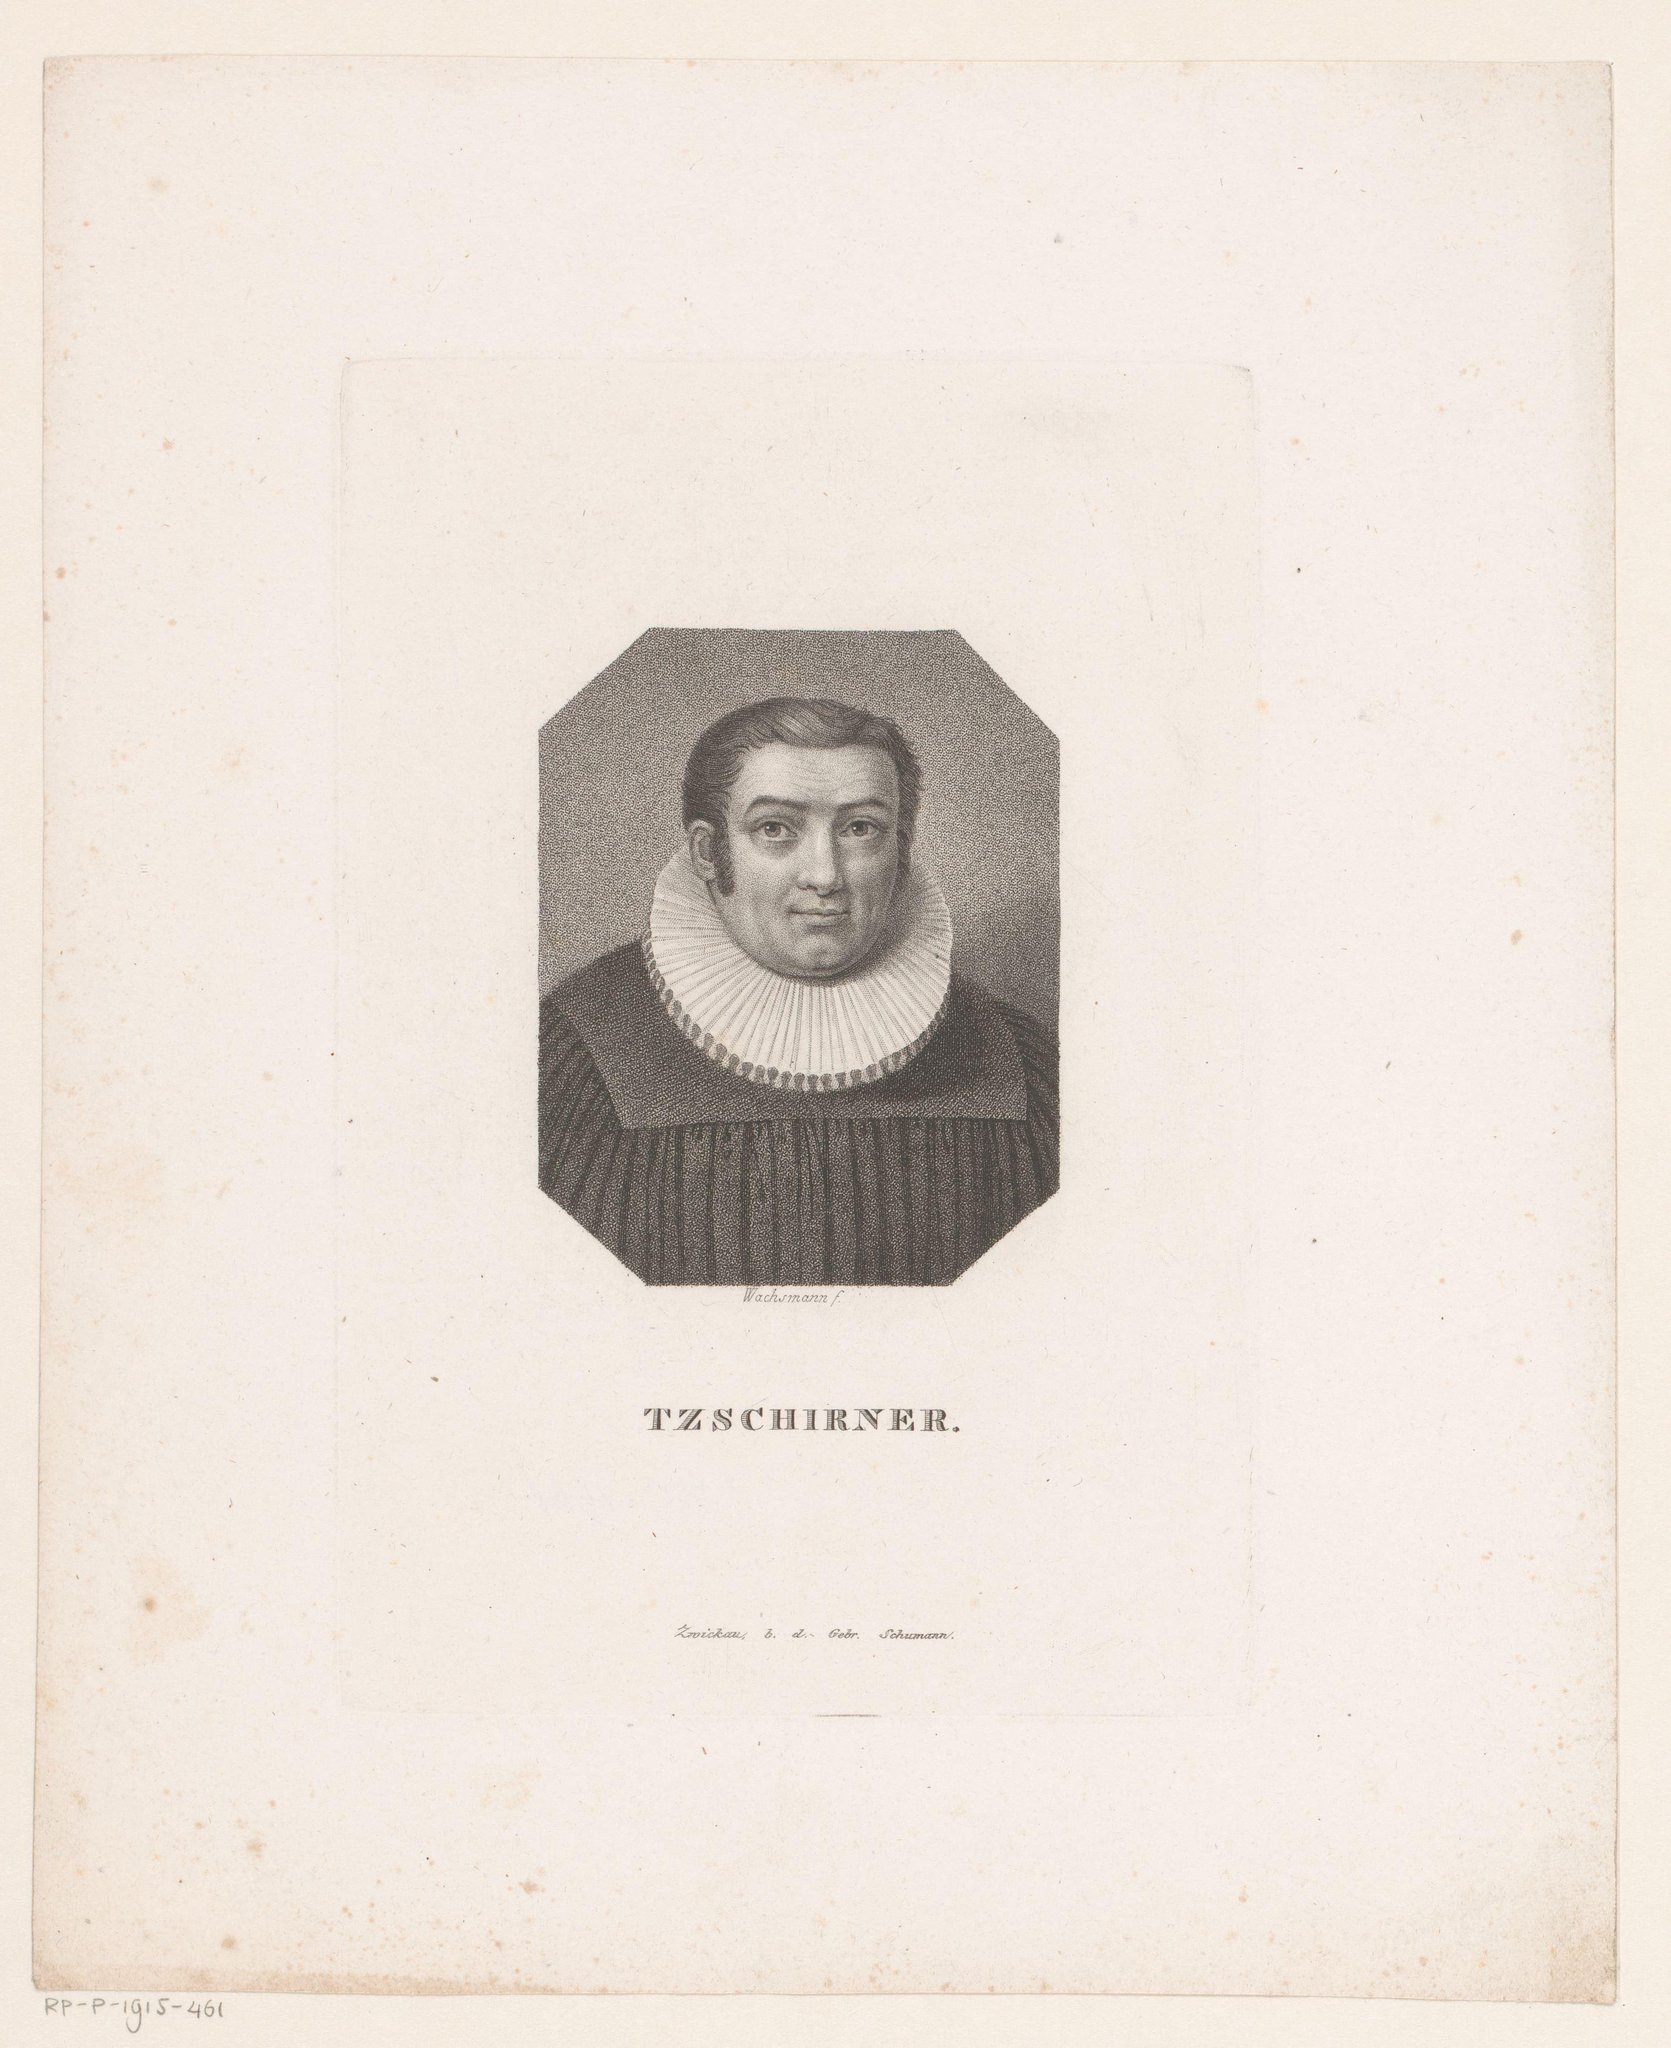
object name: print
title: Portretten van beroemde mensen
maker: anton wachsmann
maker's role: print maker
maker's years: 1765-1836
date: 1818-1832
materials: paper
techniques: engraving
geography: germany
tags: historical persons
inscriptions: collector's mark: Lugt 2228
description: Prent gebruikt door de serie 'Bildnisse der berühmtesten Menschen aller Völker und Zeiten', uitgegeven door de gebroeders Schumann in 1818-1832 te Zwickau.